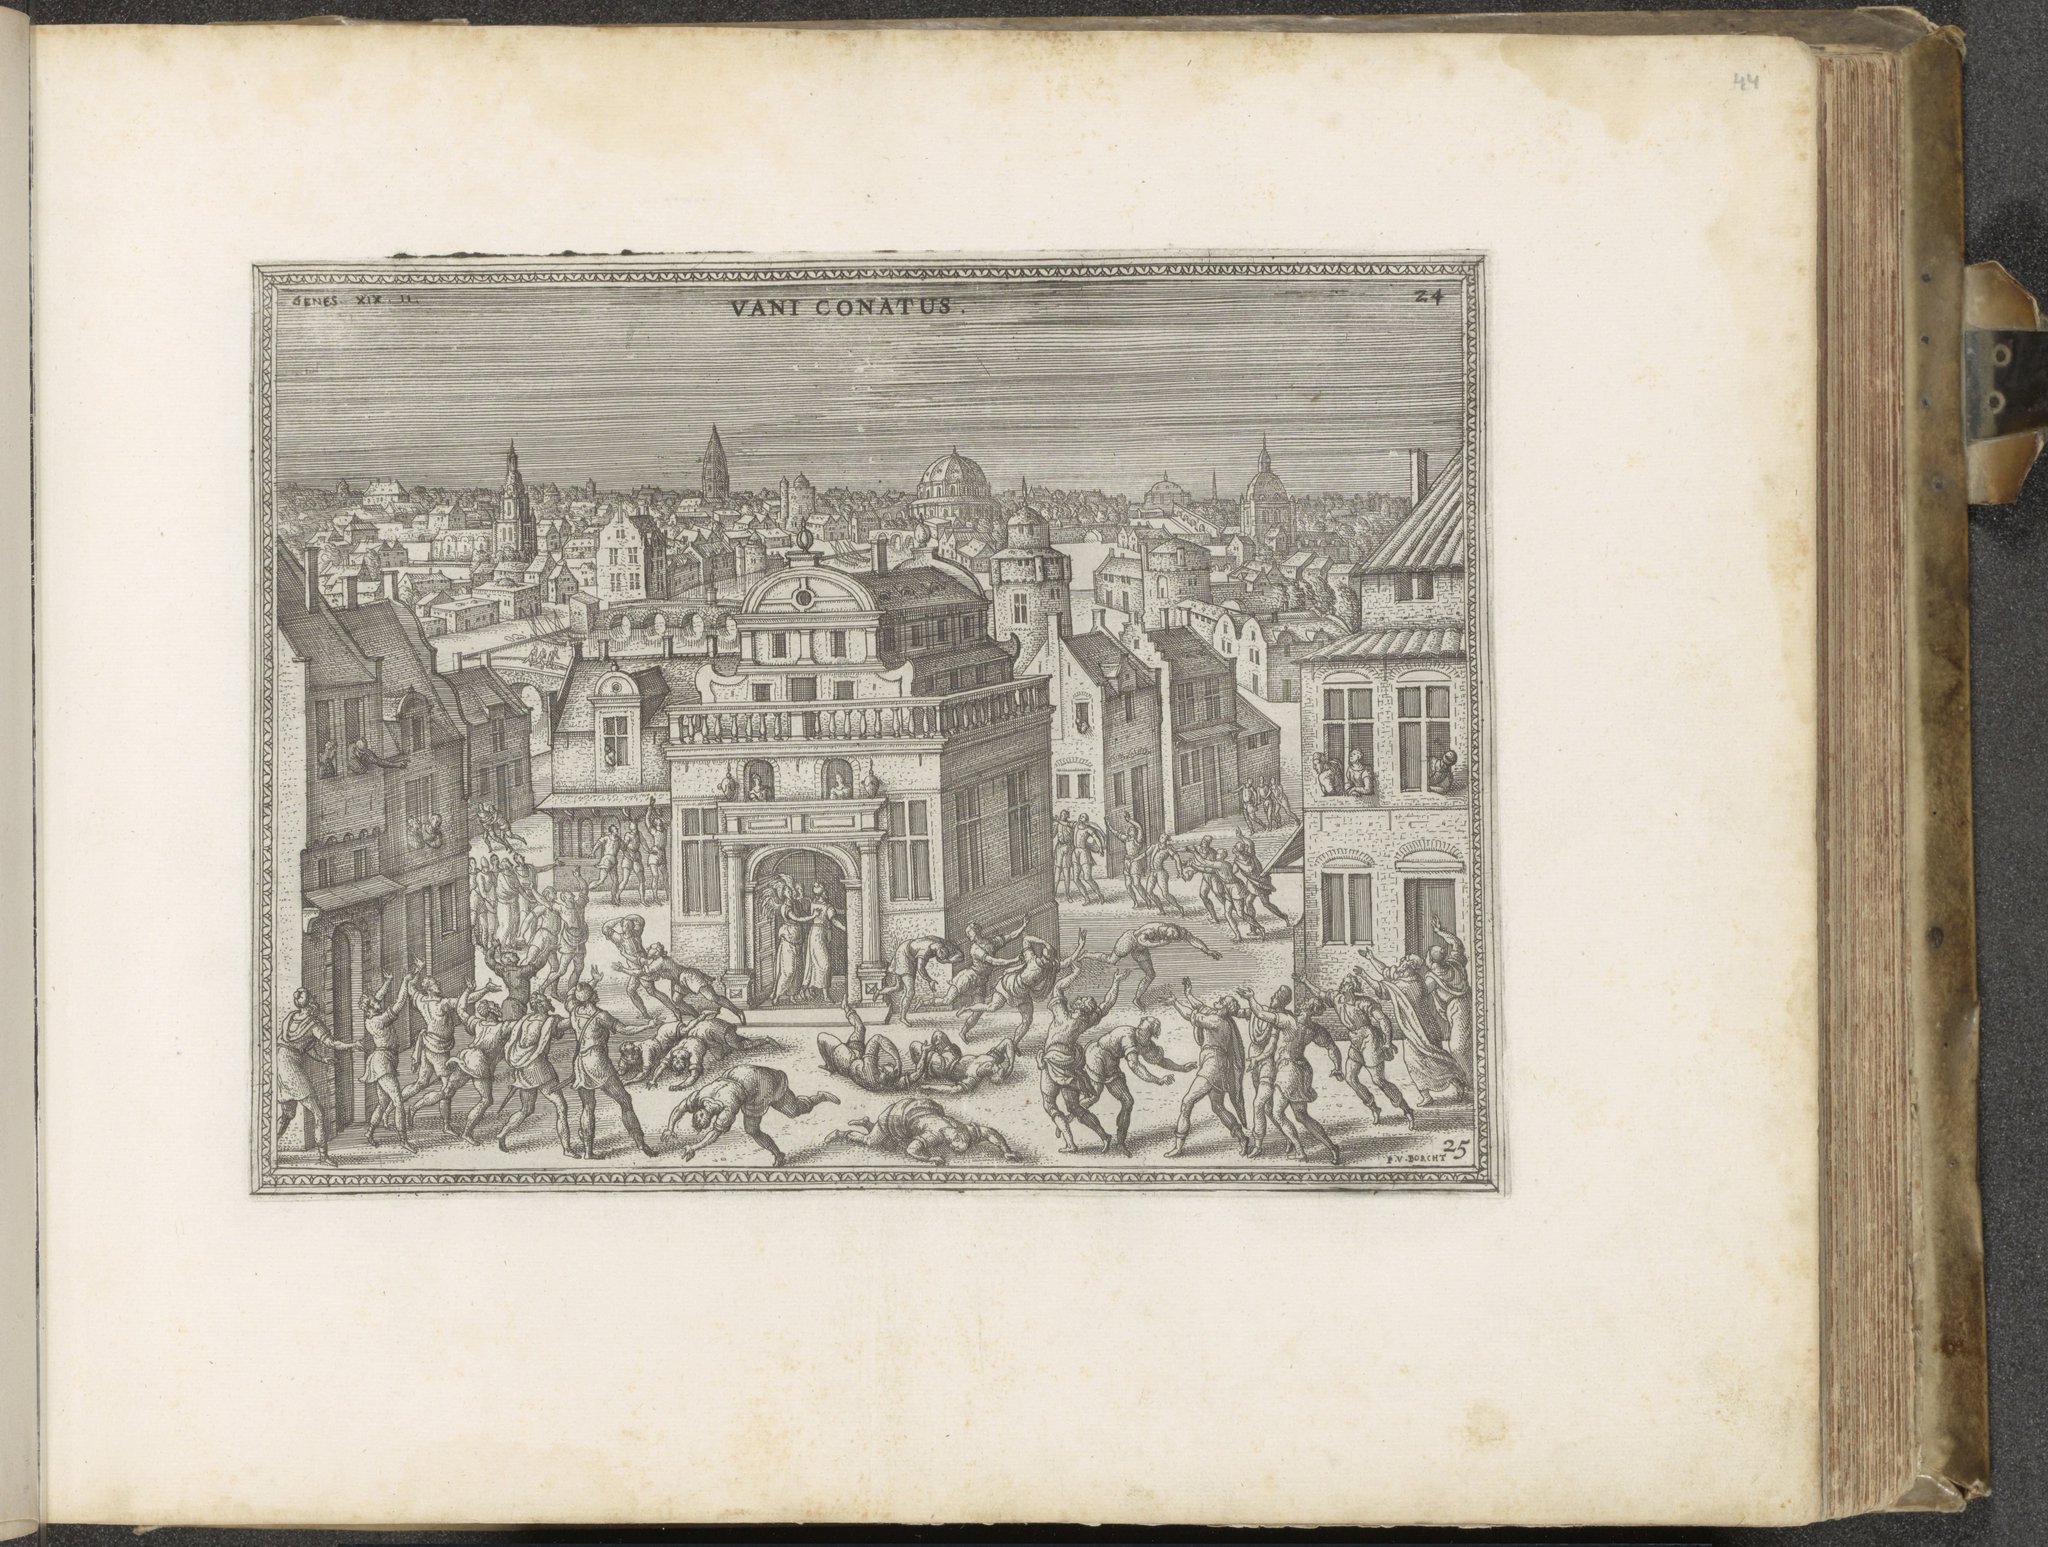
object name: album leaf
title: Den Grooten Emblemata Sacra, bestaande in meer dan vier hondert bybelsche figuren, zoo des Ouden als des Nieuwen Testaments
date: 1582-1593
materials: paper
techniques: etching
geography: amsterdam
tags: old testament, the two angels intervene and strike the mob that surround lot's house with blindness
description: De mannen die bij het huis van Lot zijn verzameld, worden door God met blindheid geslagen. In de deuropening Lot en de twee engelen die hij had uitgenodigd voor de maaltijd en een overnachting bij hem thuis (Gen. 19:11). De prent maakt deel uit van een album.